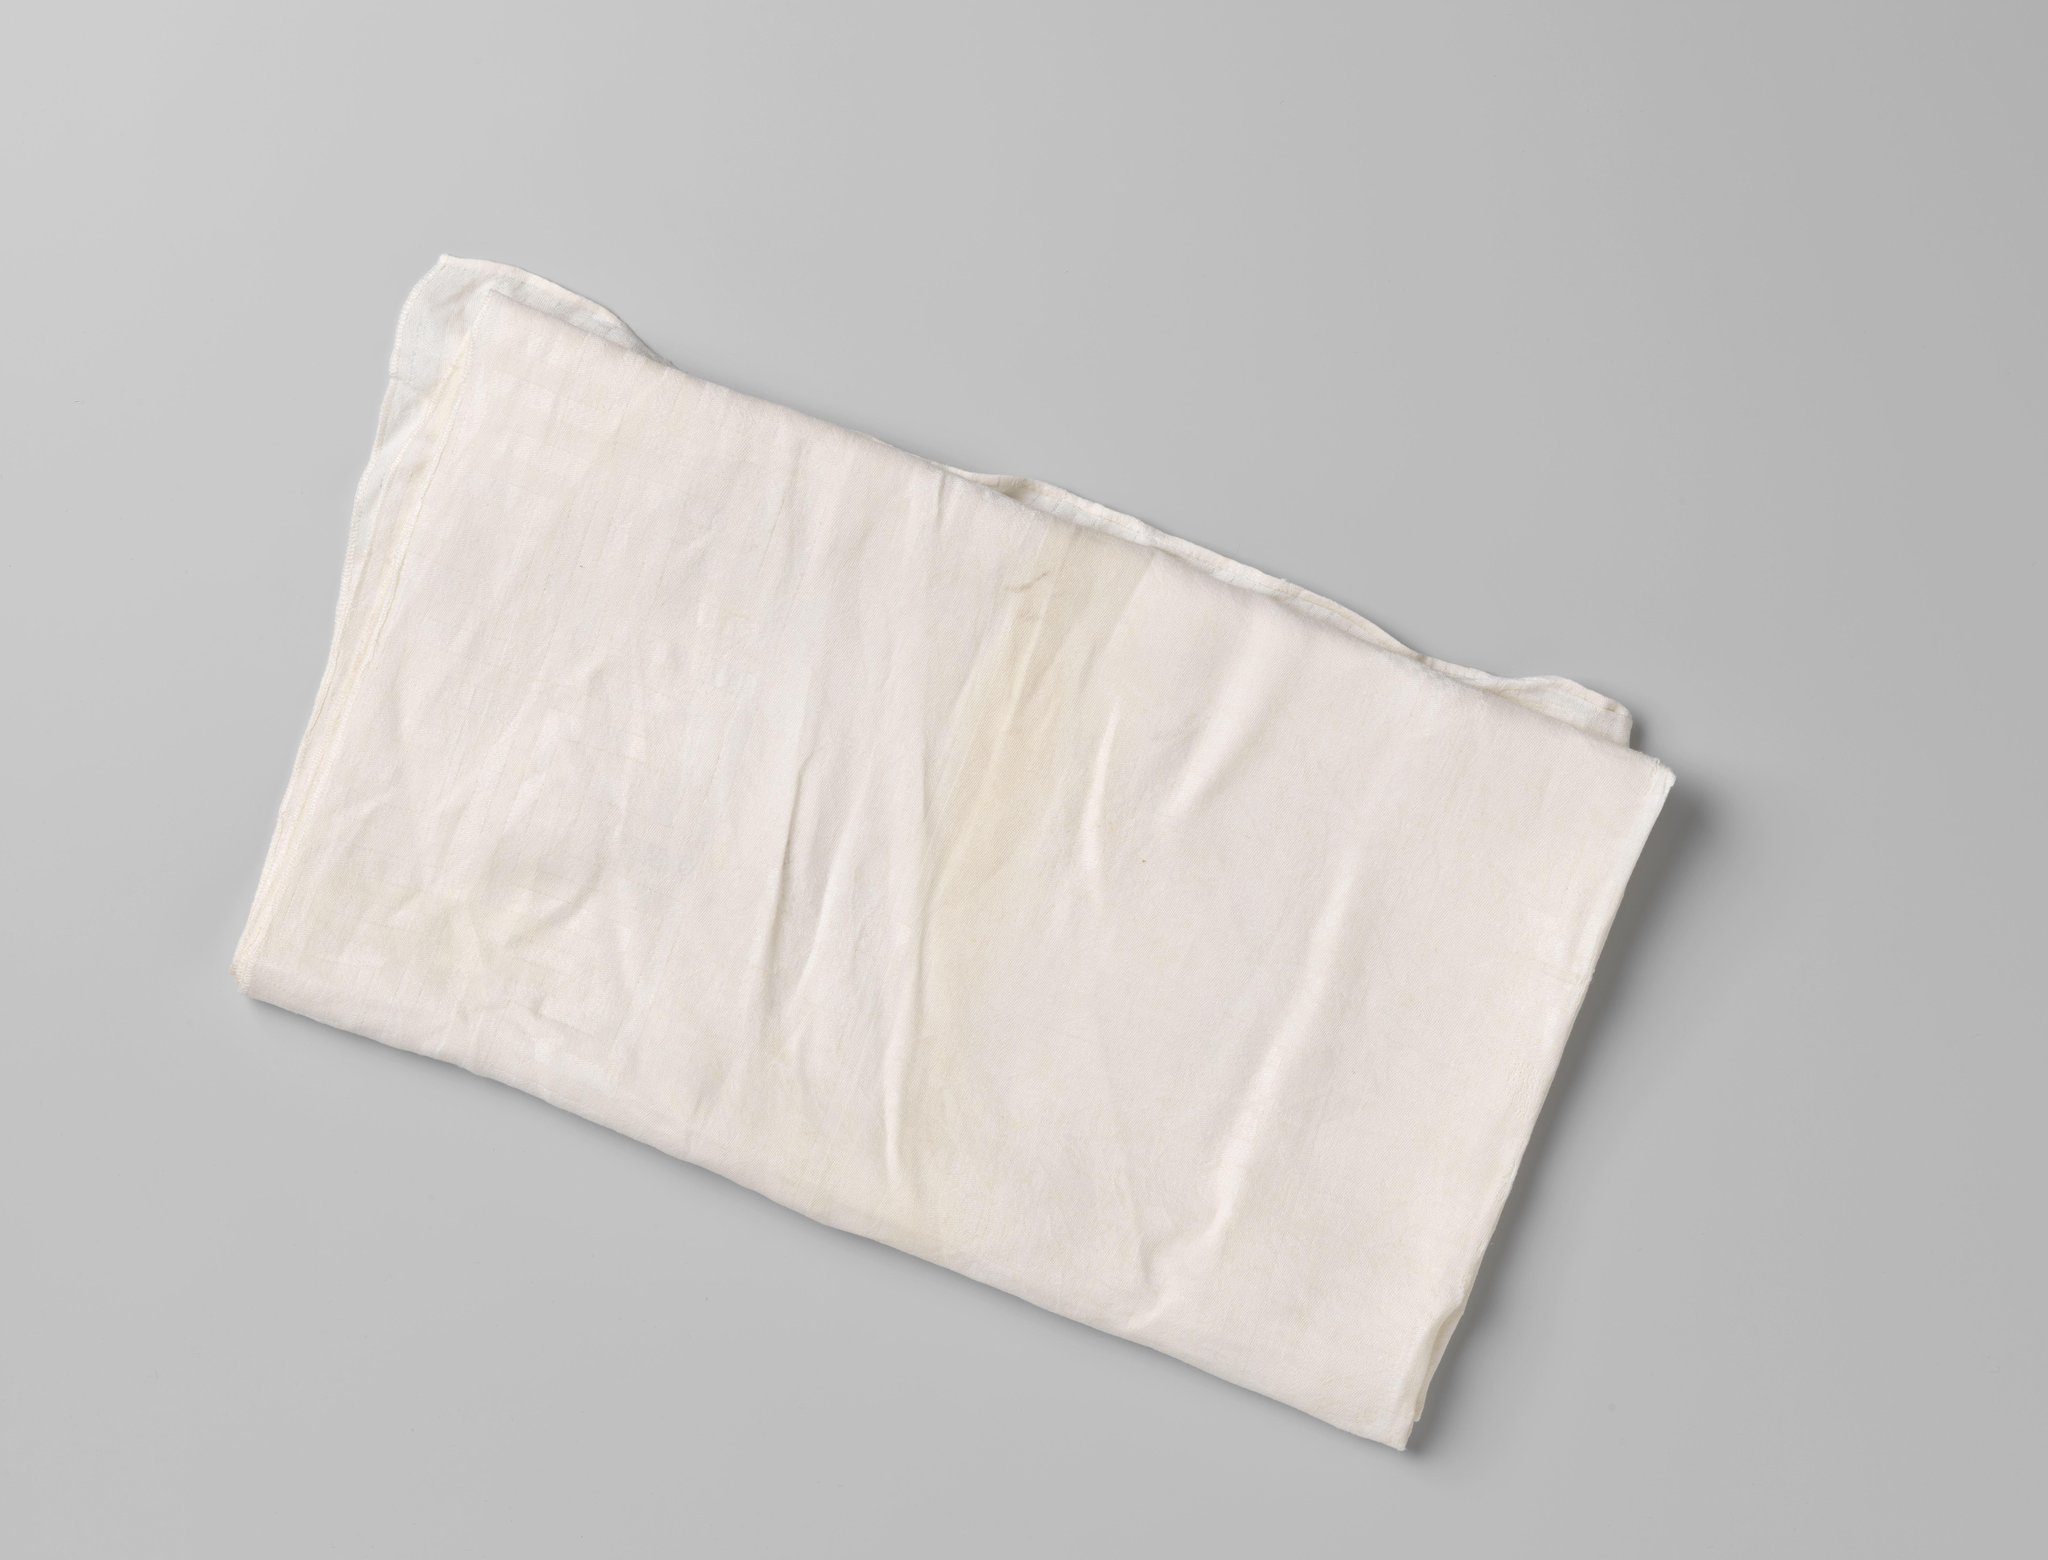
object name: cloth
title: Doek van gala-kostuum van lid Erewacht tijdens de inhuldiging van koningin Juliana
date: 1909-1948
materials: linen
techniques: damask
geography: netherlands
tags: erich hartmann, the hague, juliana of the netherlands, amsterdam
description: Damasten doek met langs de rand rechthoekige, geometrische figuren en achtpuntige stermotieven op middenvlak. In een hoek met rood draad geborduurd: SRO. In deze doek waren de pantalon en de rok gewikkeld die gedragen zijn door Ernst Hartmann, lid Erewacht, tijdens de inhuldiging van koningin Juliana op 6 september 1948.